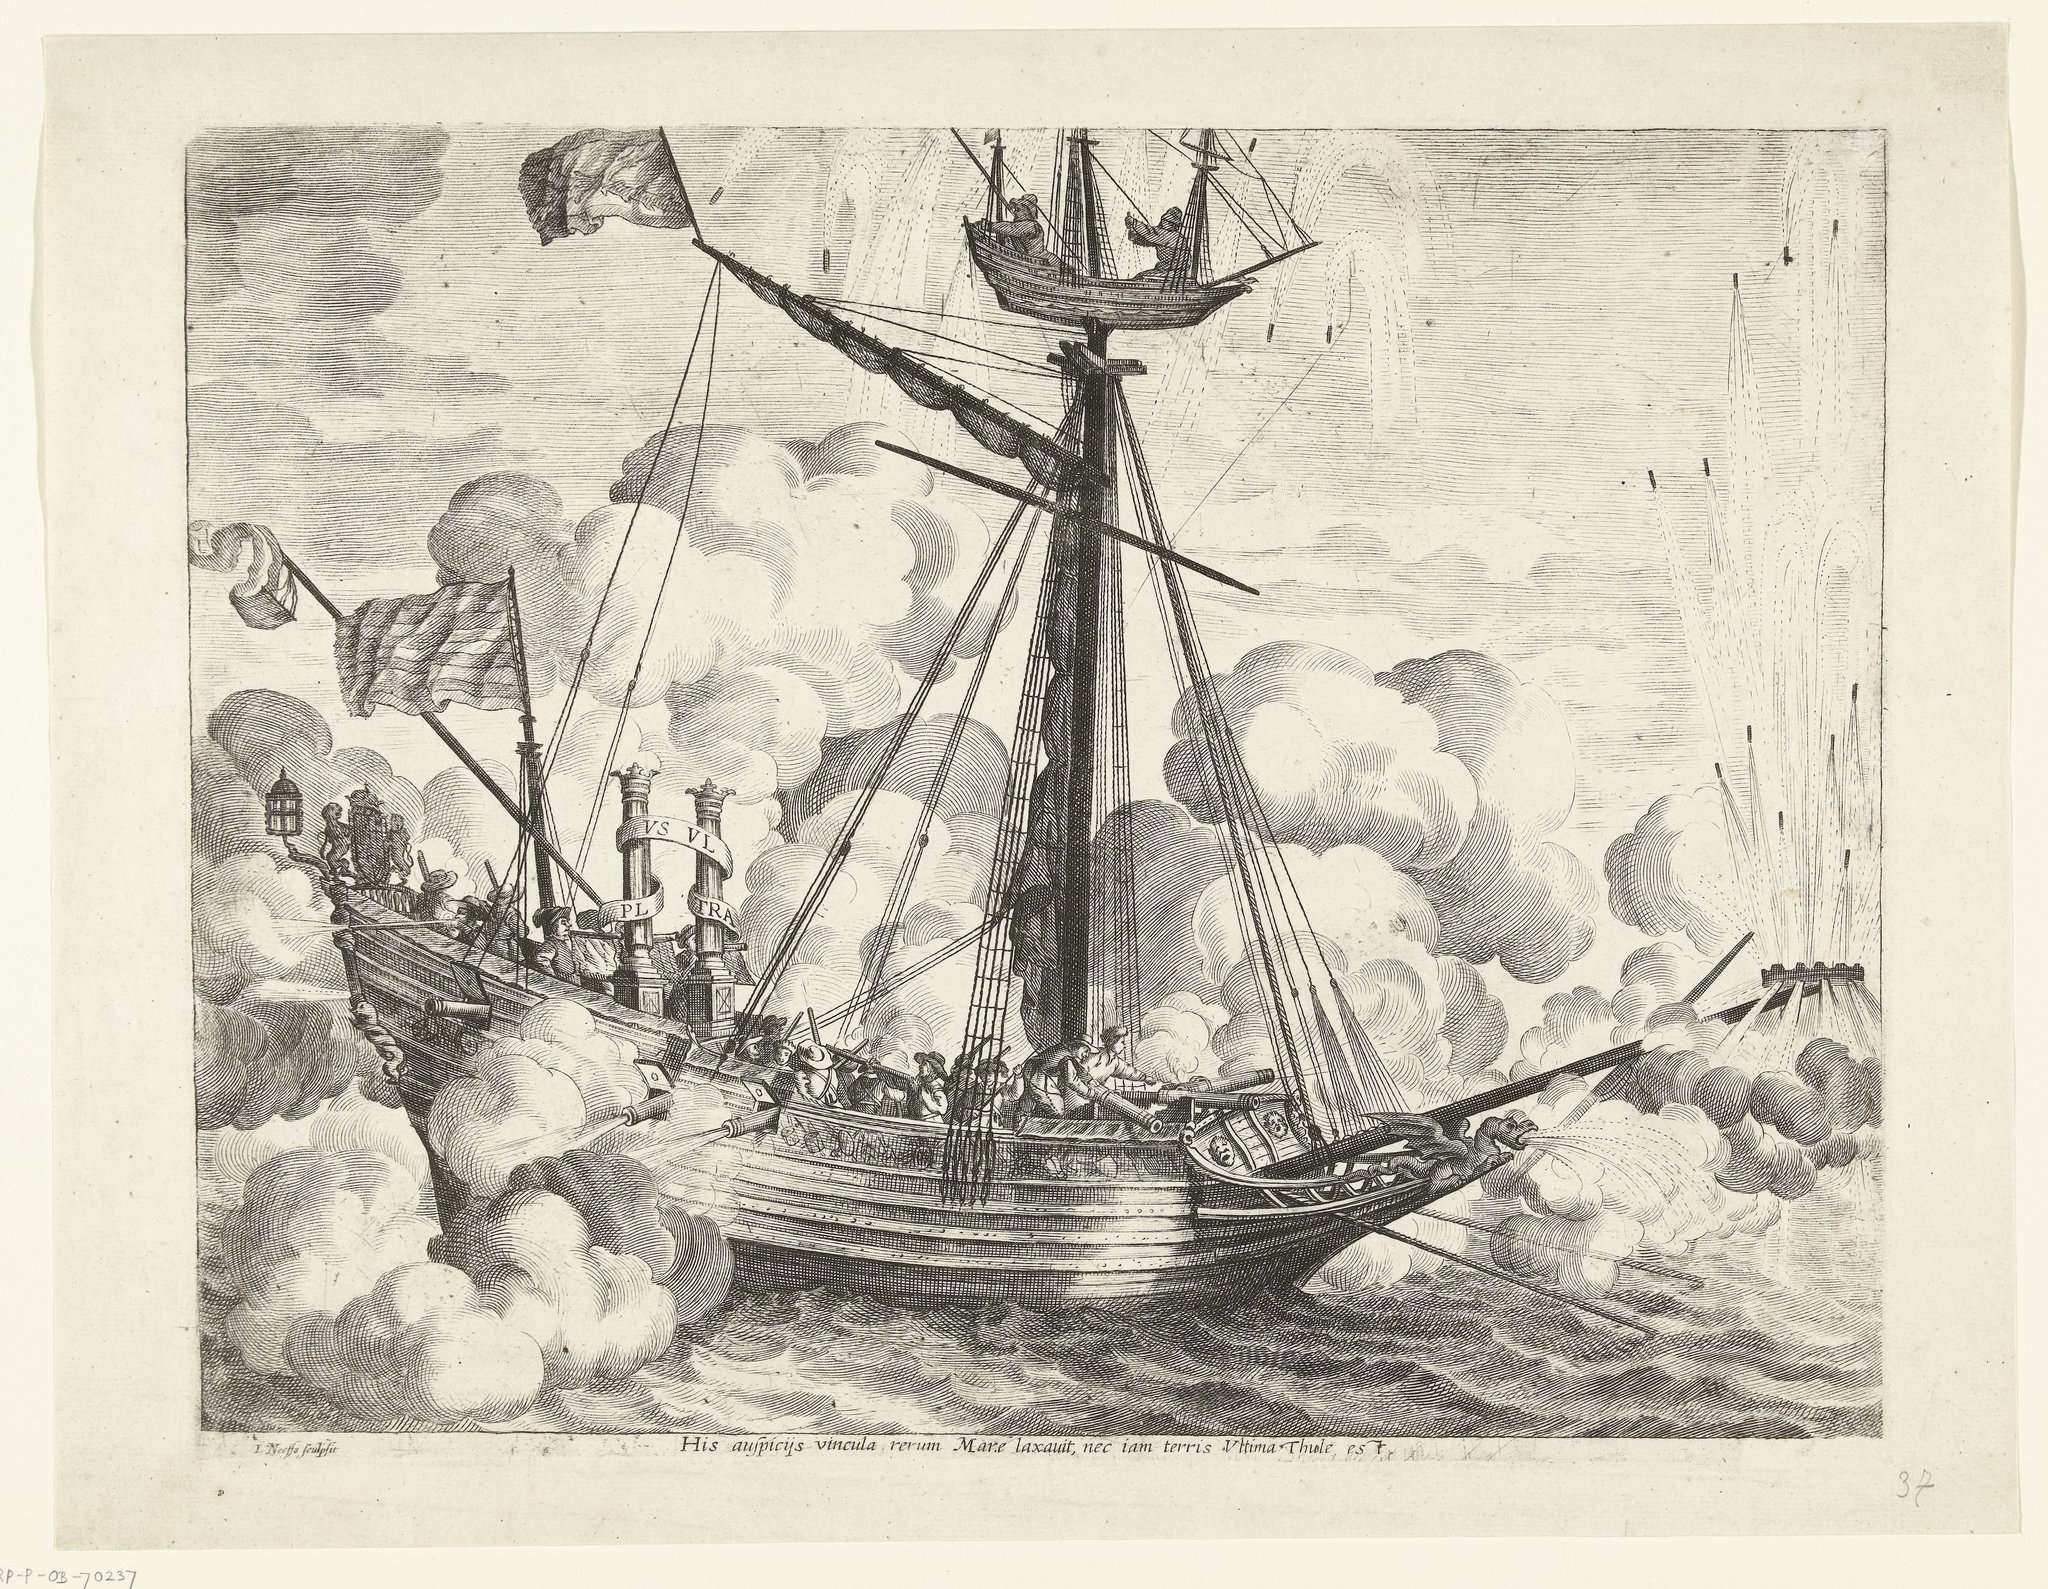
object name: print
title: Liberorum nautarum navis triumphalis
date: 1635-1636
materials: paper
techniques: engraving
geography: southern netherlands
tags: landvoogd der zuidelijke nederlanden ferdinand van oostenrijk, ships (in general) (+ propulsion of vehicle, ship, etc. by wind), triumphal entry and public reception, pageant, 'entrée solennelle', 'joyeuse entrée', bonfire, fire-works, ghent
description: Spektakel met schip met vuurwerk, vurende kanonnen en de zuilen van Hercules. Blad nr. 37 in een geheel van 42 platen die de uitgave van de beschrijving van de intocht van de Kardinaal Infant Ferdinand van Oostenrijk te Gent op 28 januari 1635 als de nieuwe landvoogd voor de Spaanse Nederlanden illustreren.